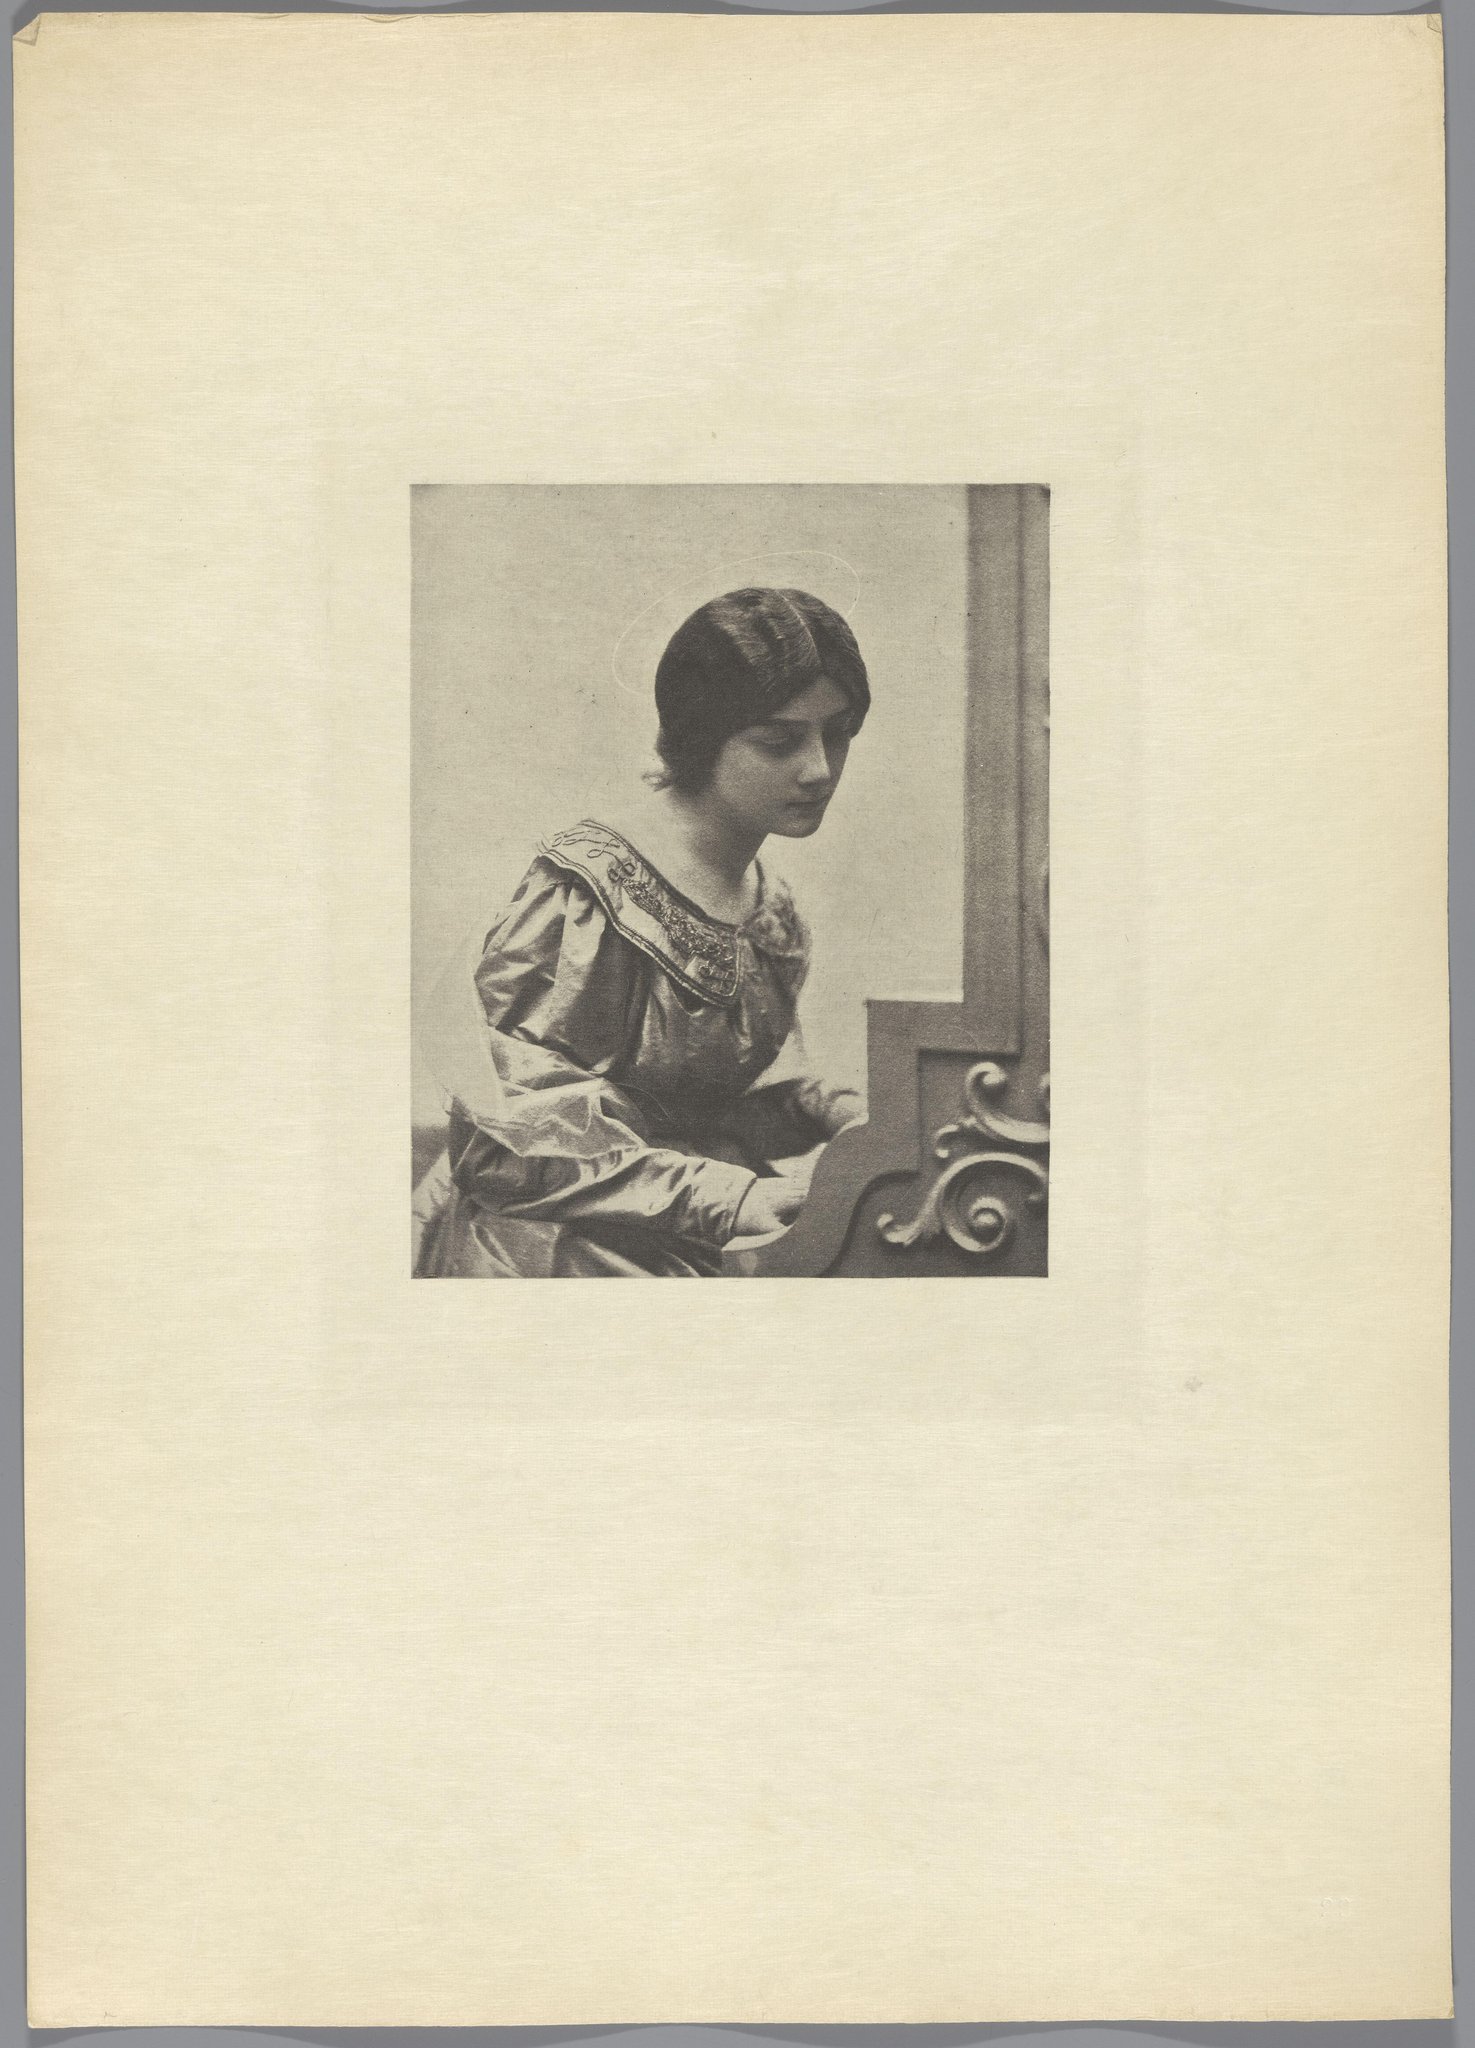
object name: photomechanical print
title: Portret van een onbekende vrouw als de heilige Cecilia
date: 1891-1896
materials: paper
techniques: photoaquatint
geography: paris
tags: the virgin martyr cecilia of rome; possible attributes: falcon, musical instruments, organ, wreath of roses and lilies, historical persons not known by name - bb - woman